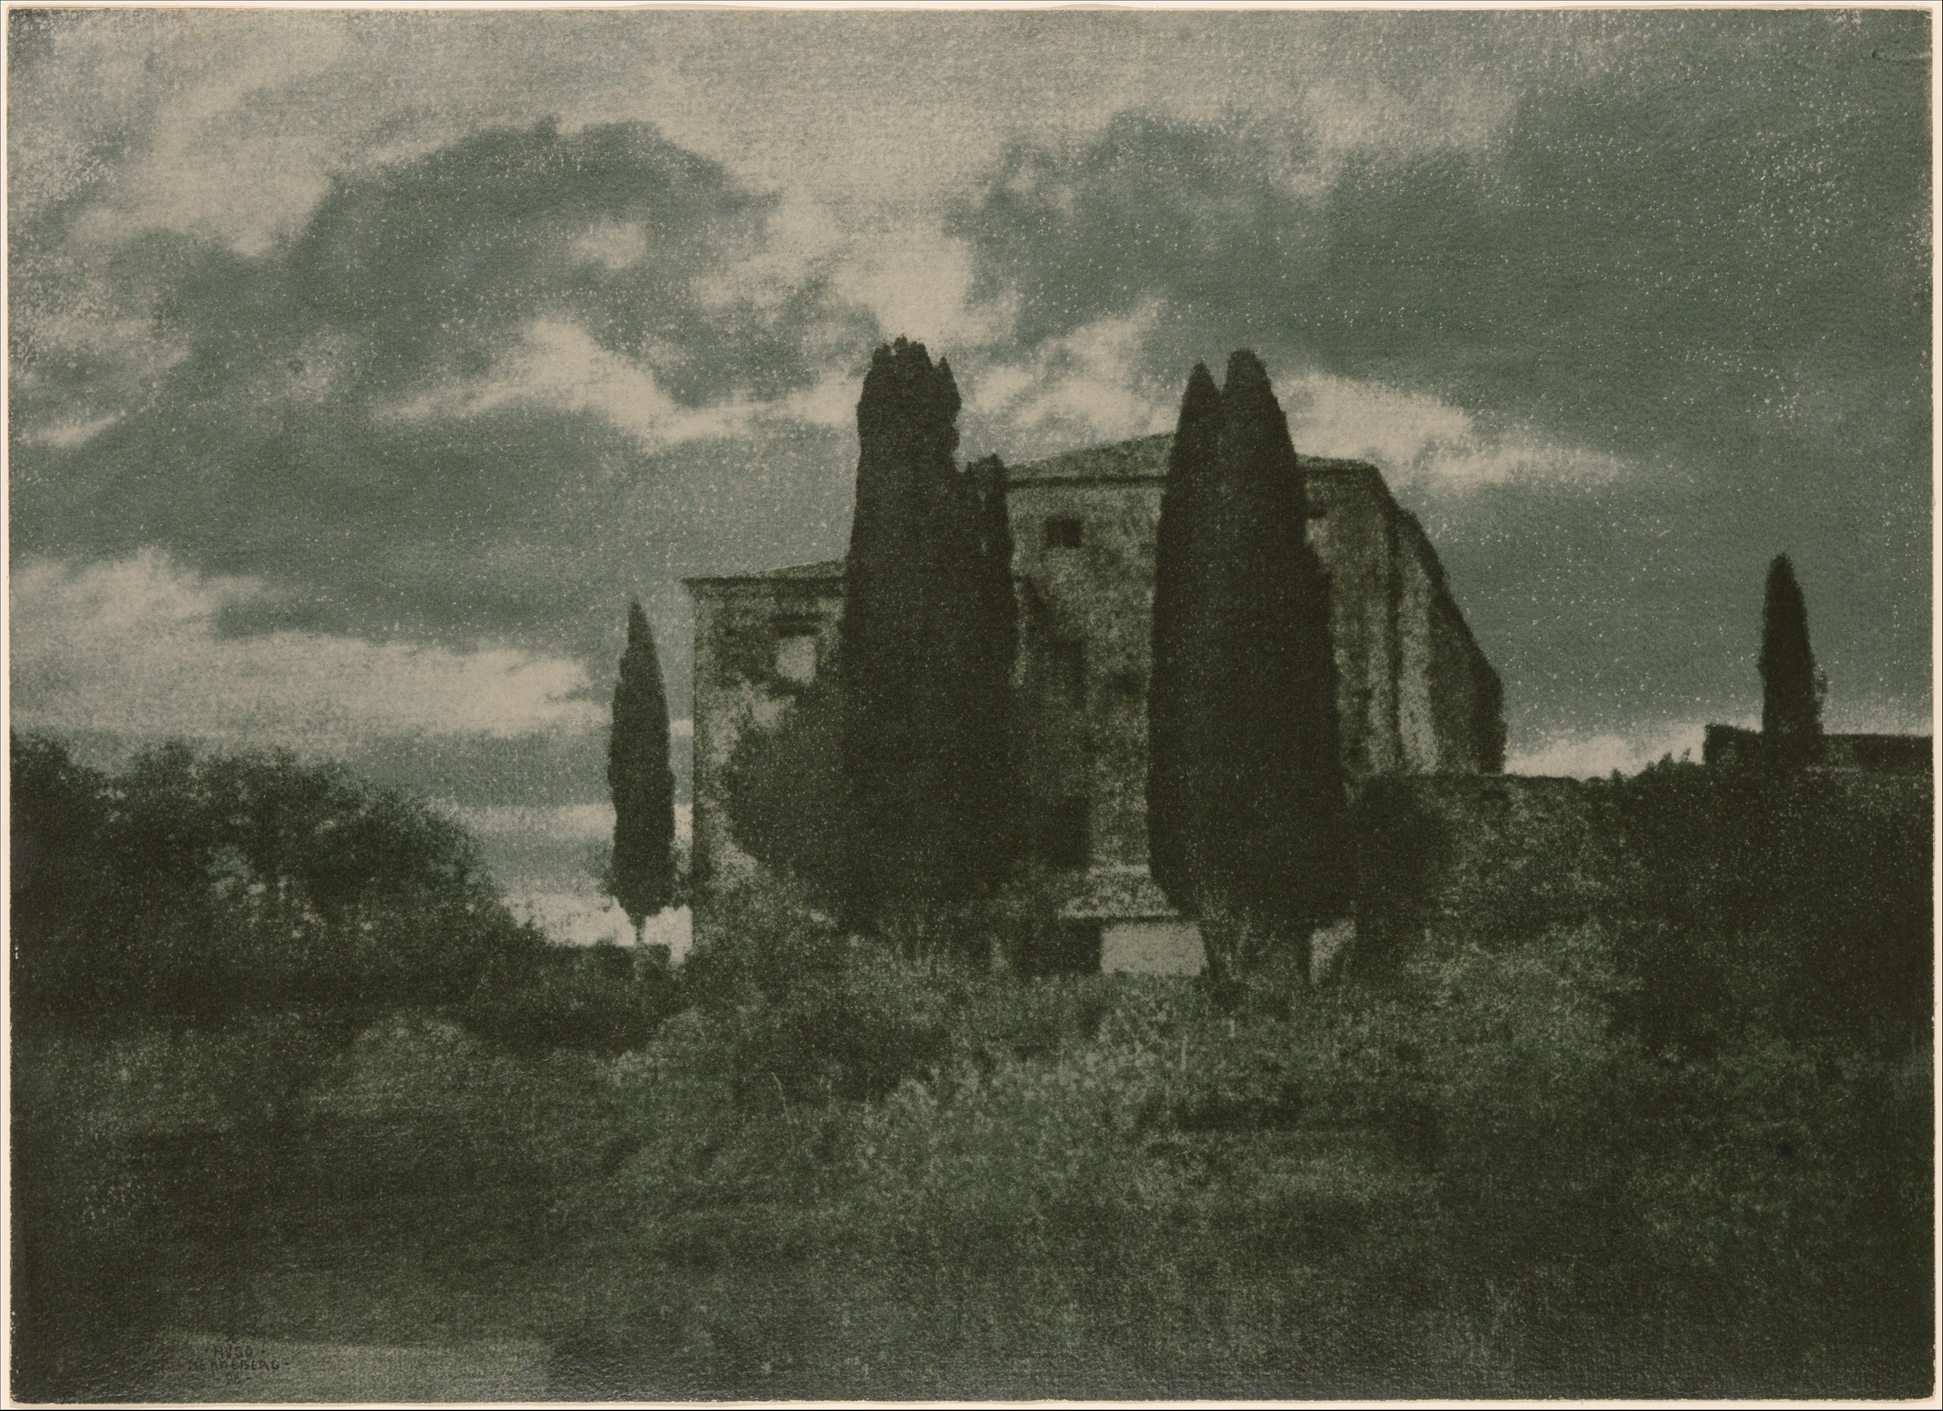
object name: photograph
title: [Italian Villa in Autumn]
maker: hugo henneberg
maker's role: fotograaf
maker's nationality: austrian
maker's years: 1863-1918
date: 1898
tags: buildings,cypresses,autumn